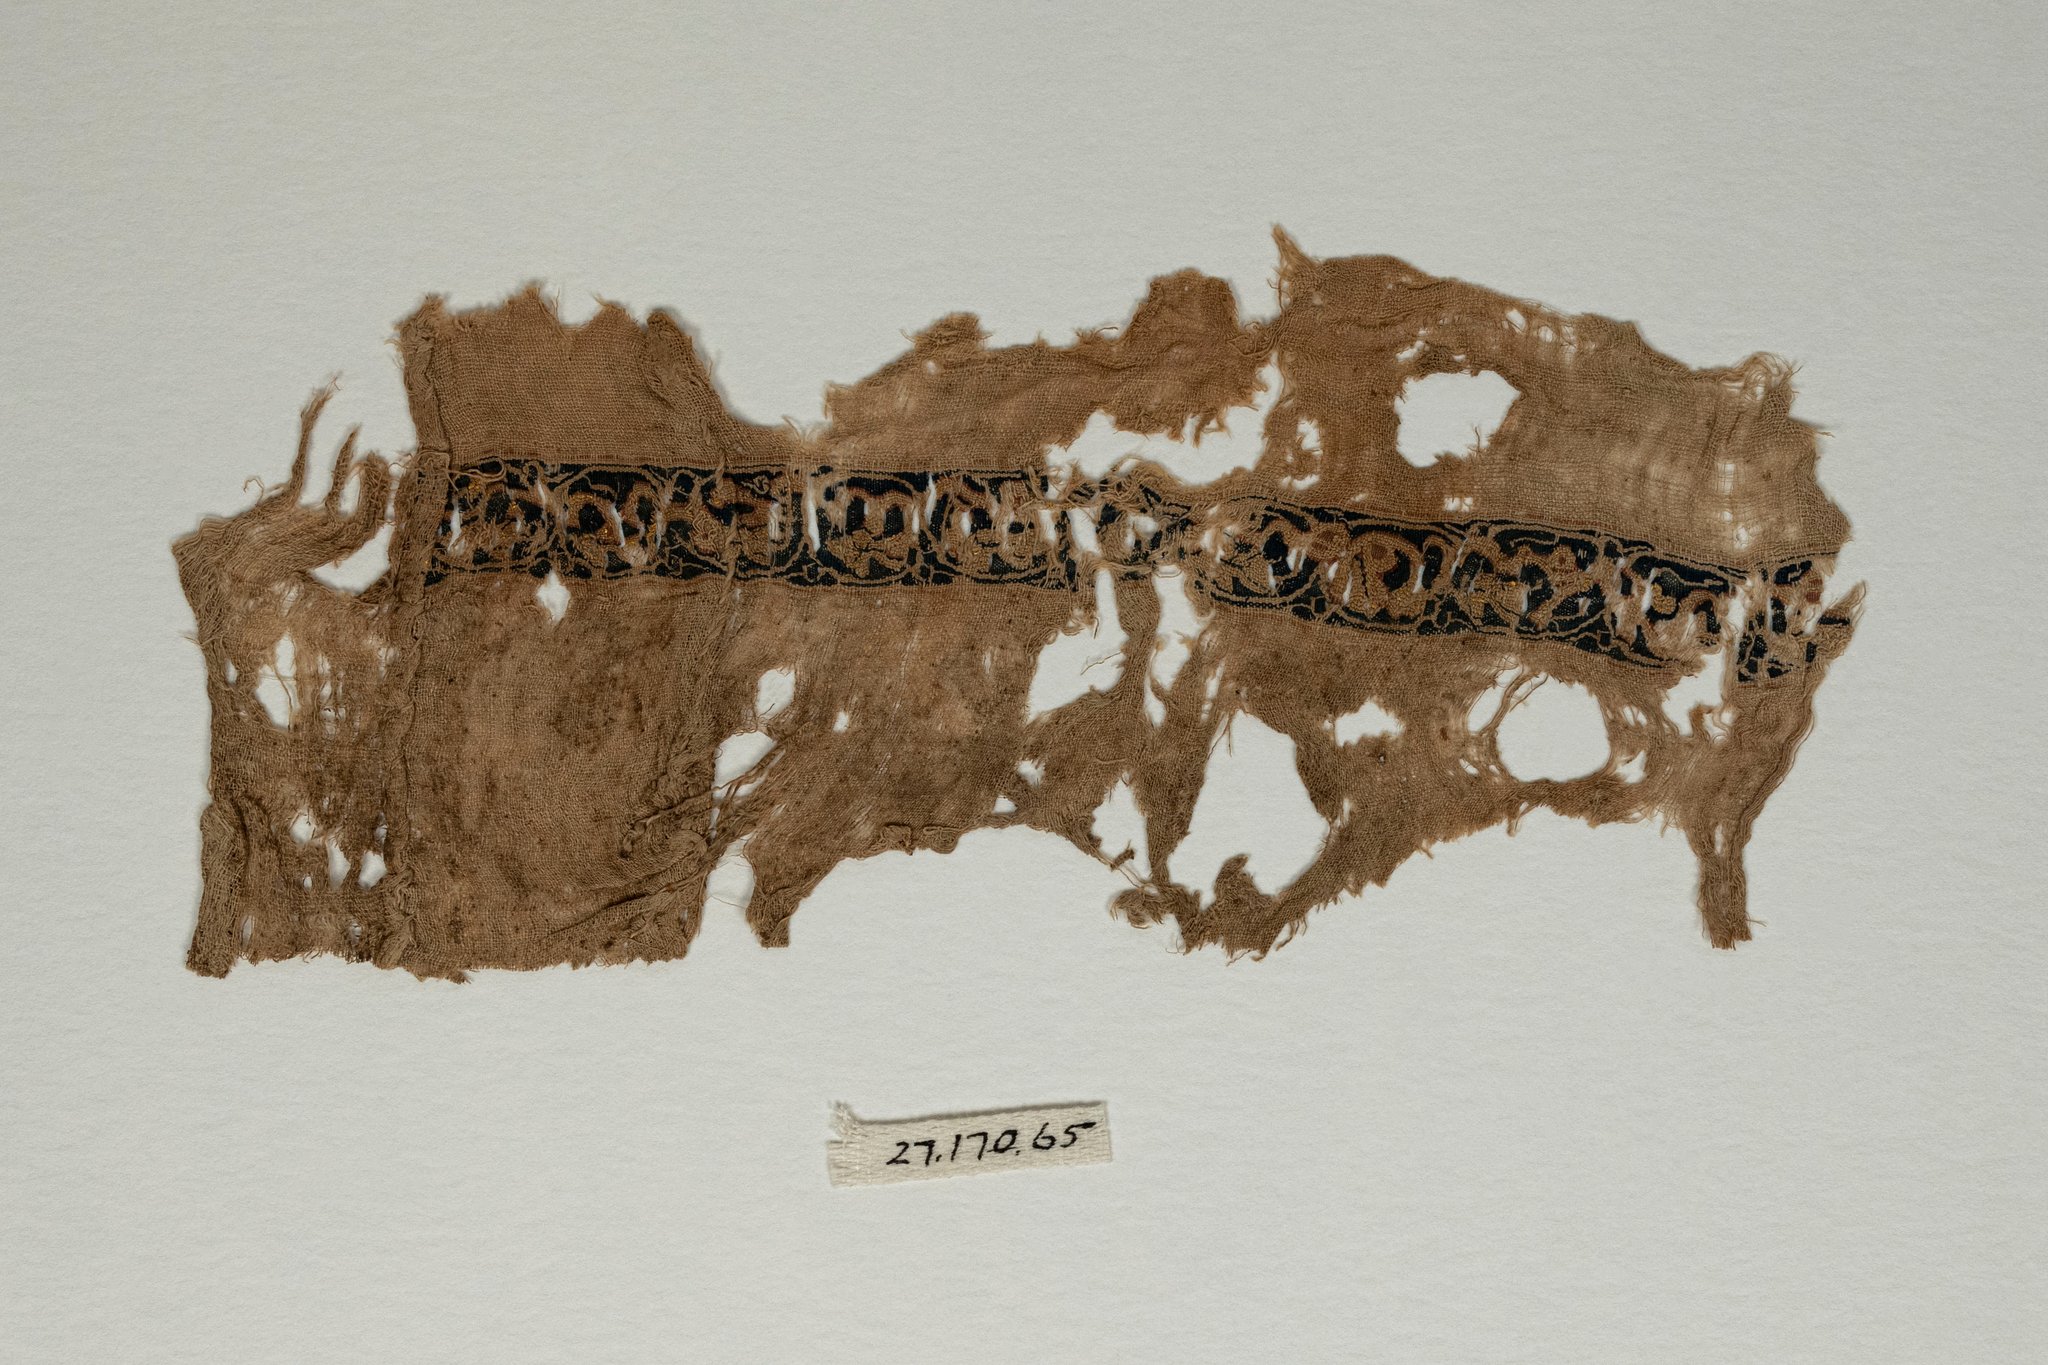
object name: textile fragment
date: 1101-1200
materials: linen, silk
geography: egypt